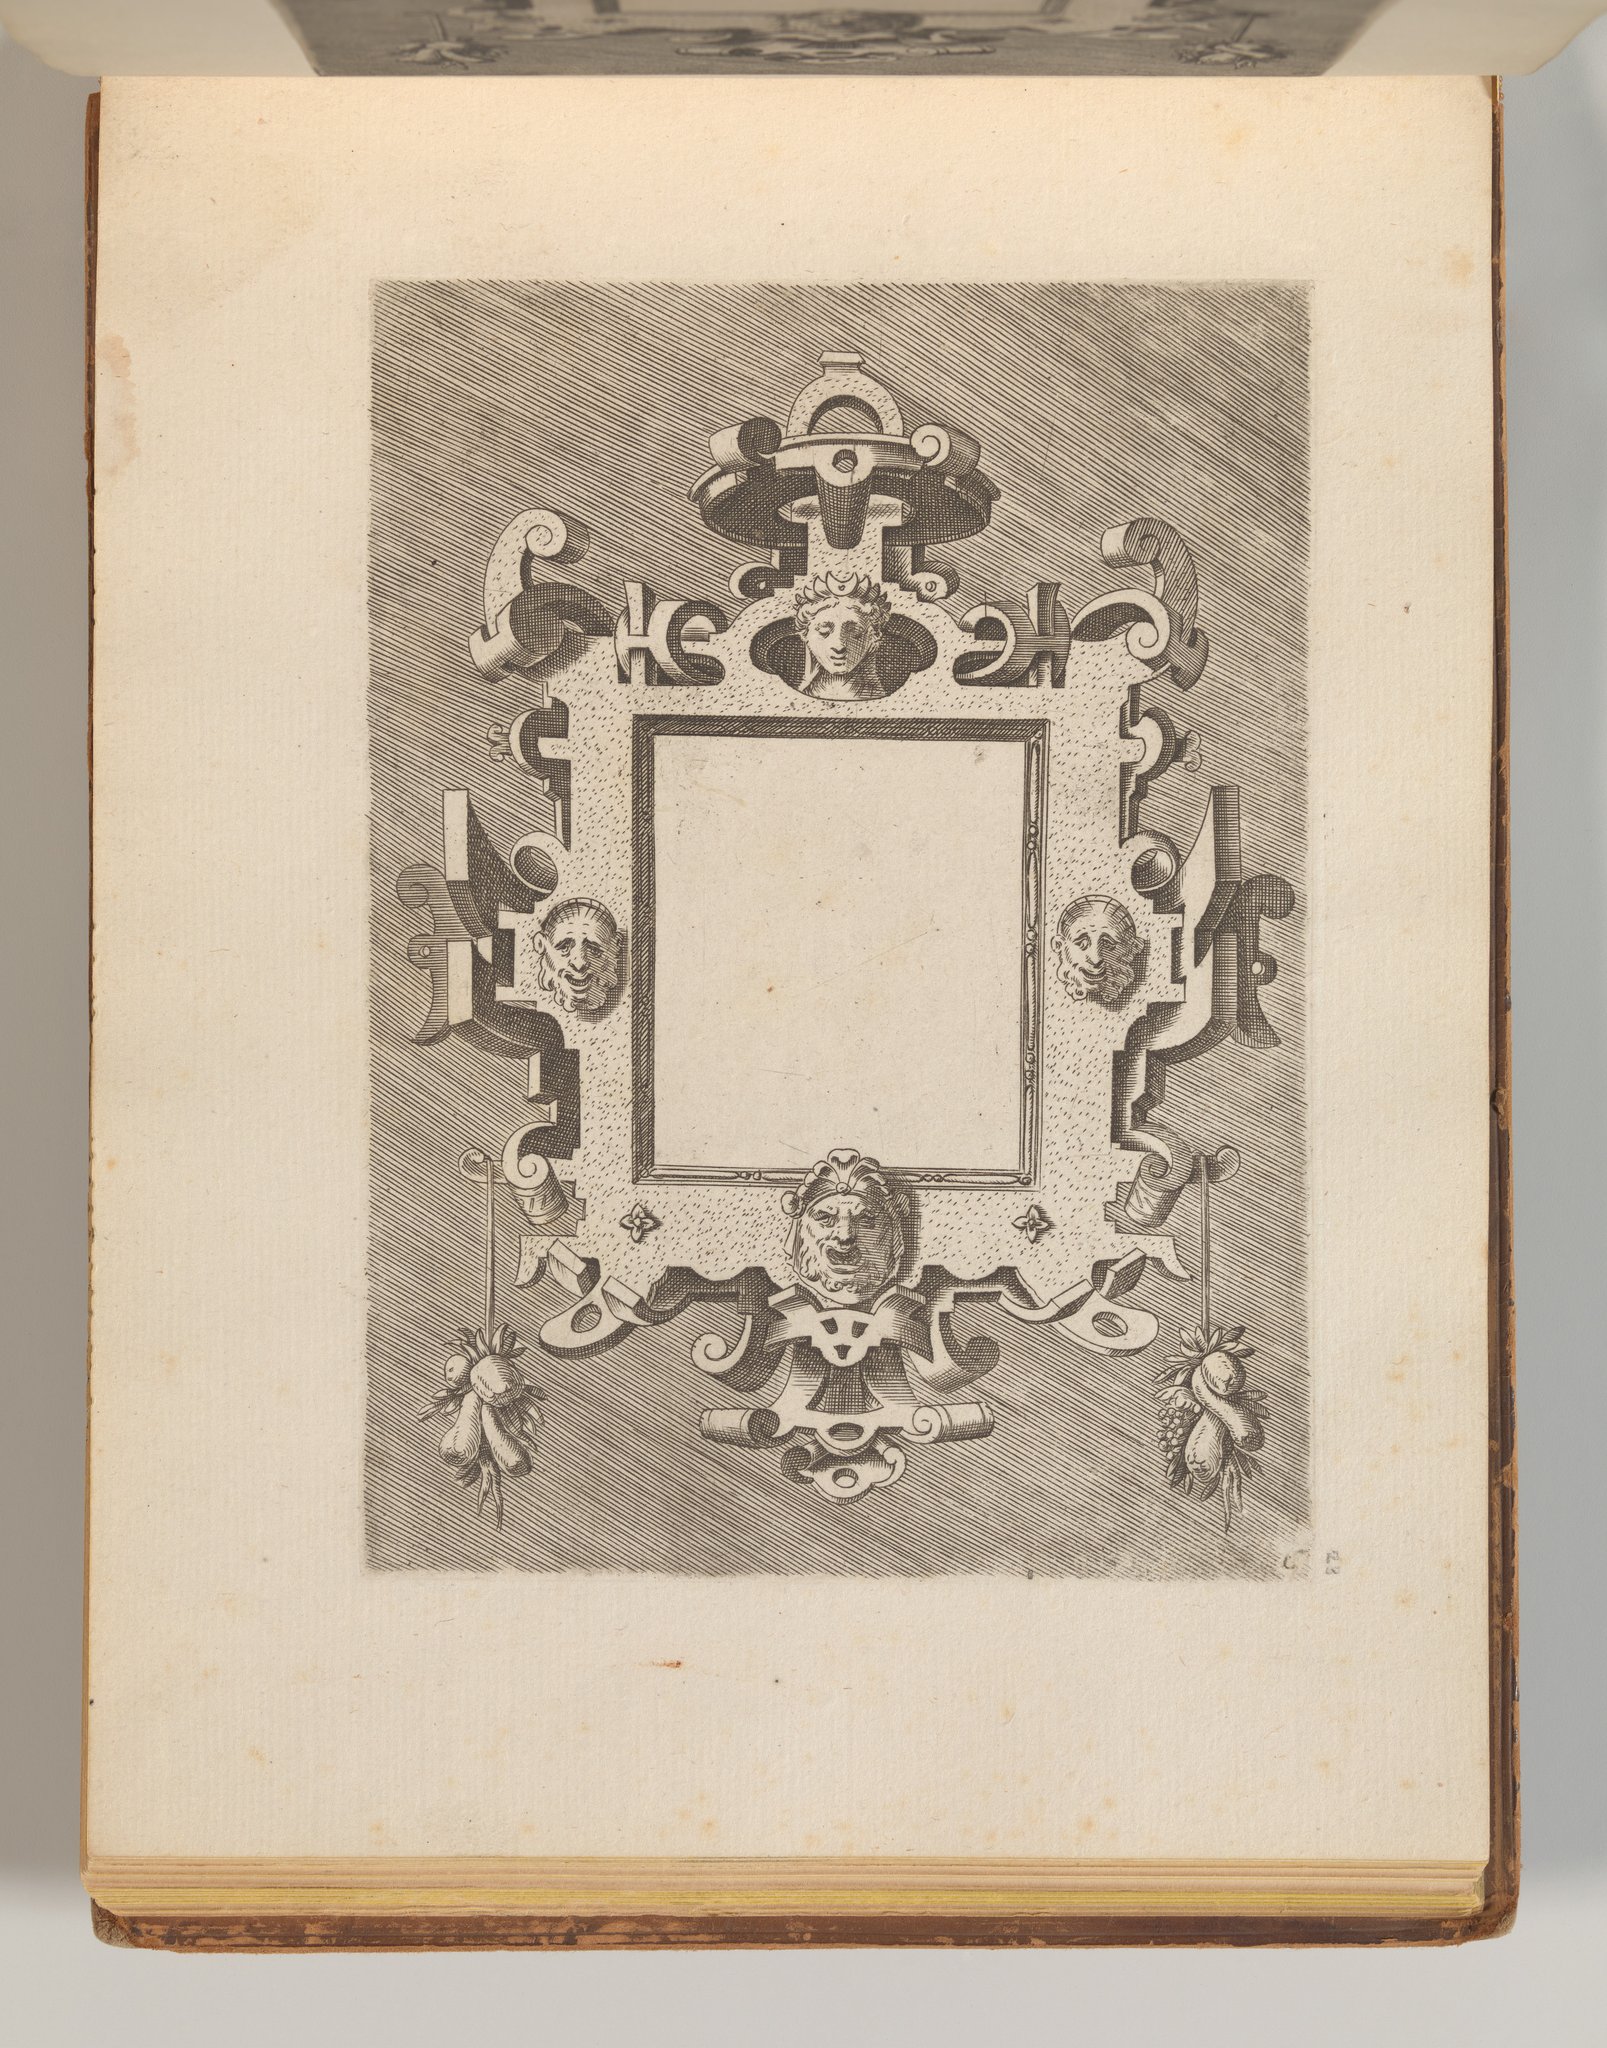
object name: album print ornament architecture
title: Targhe ed altri ornati di varie e capricciose invenzioni (Cartouches and other ornaments of various and capricious invention, page 29)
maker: hans vredeman de vries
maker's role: artist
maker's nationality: netherlandish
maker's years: 1527-1606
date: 1773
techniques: engraving, etching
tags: masks,cartouches,ornament